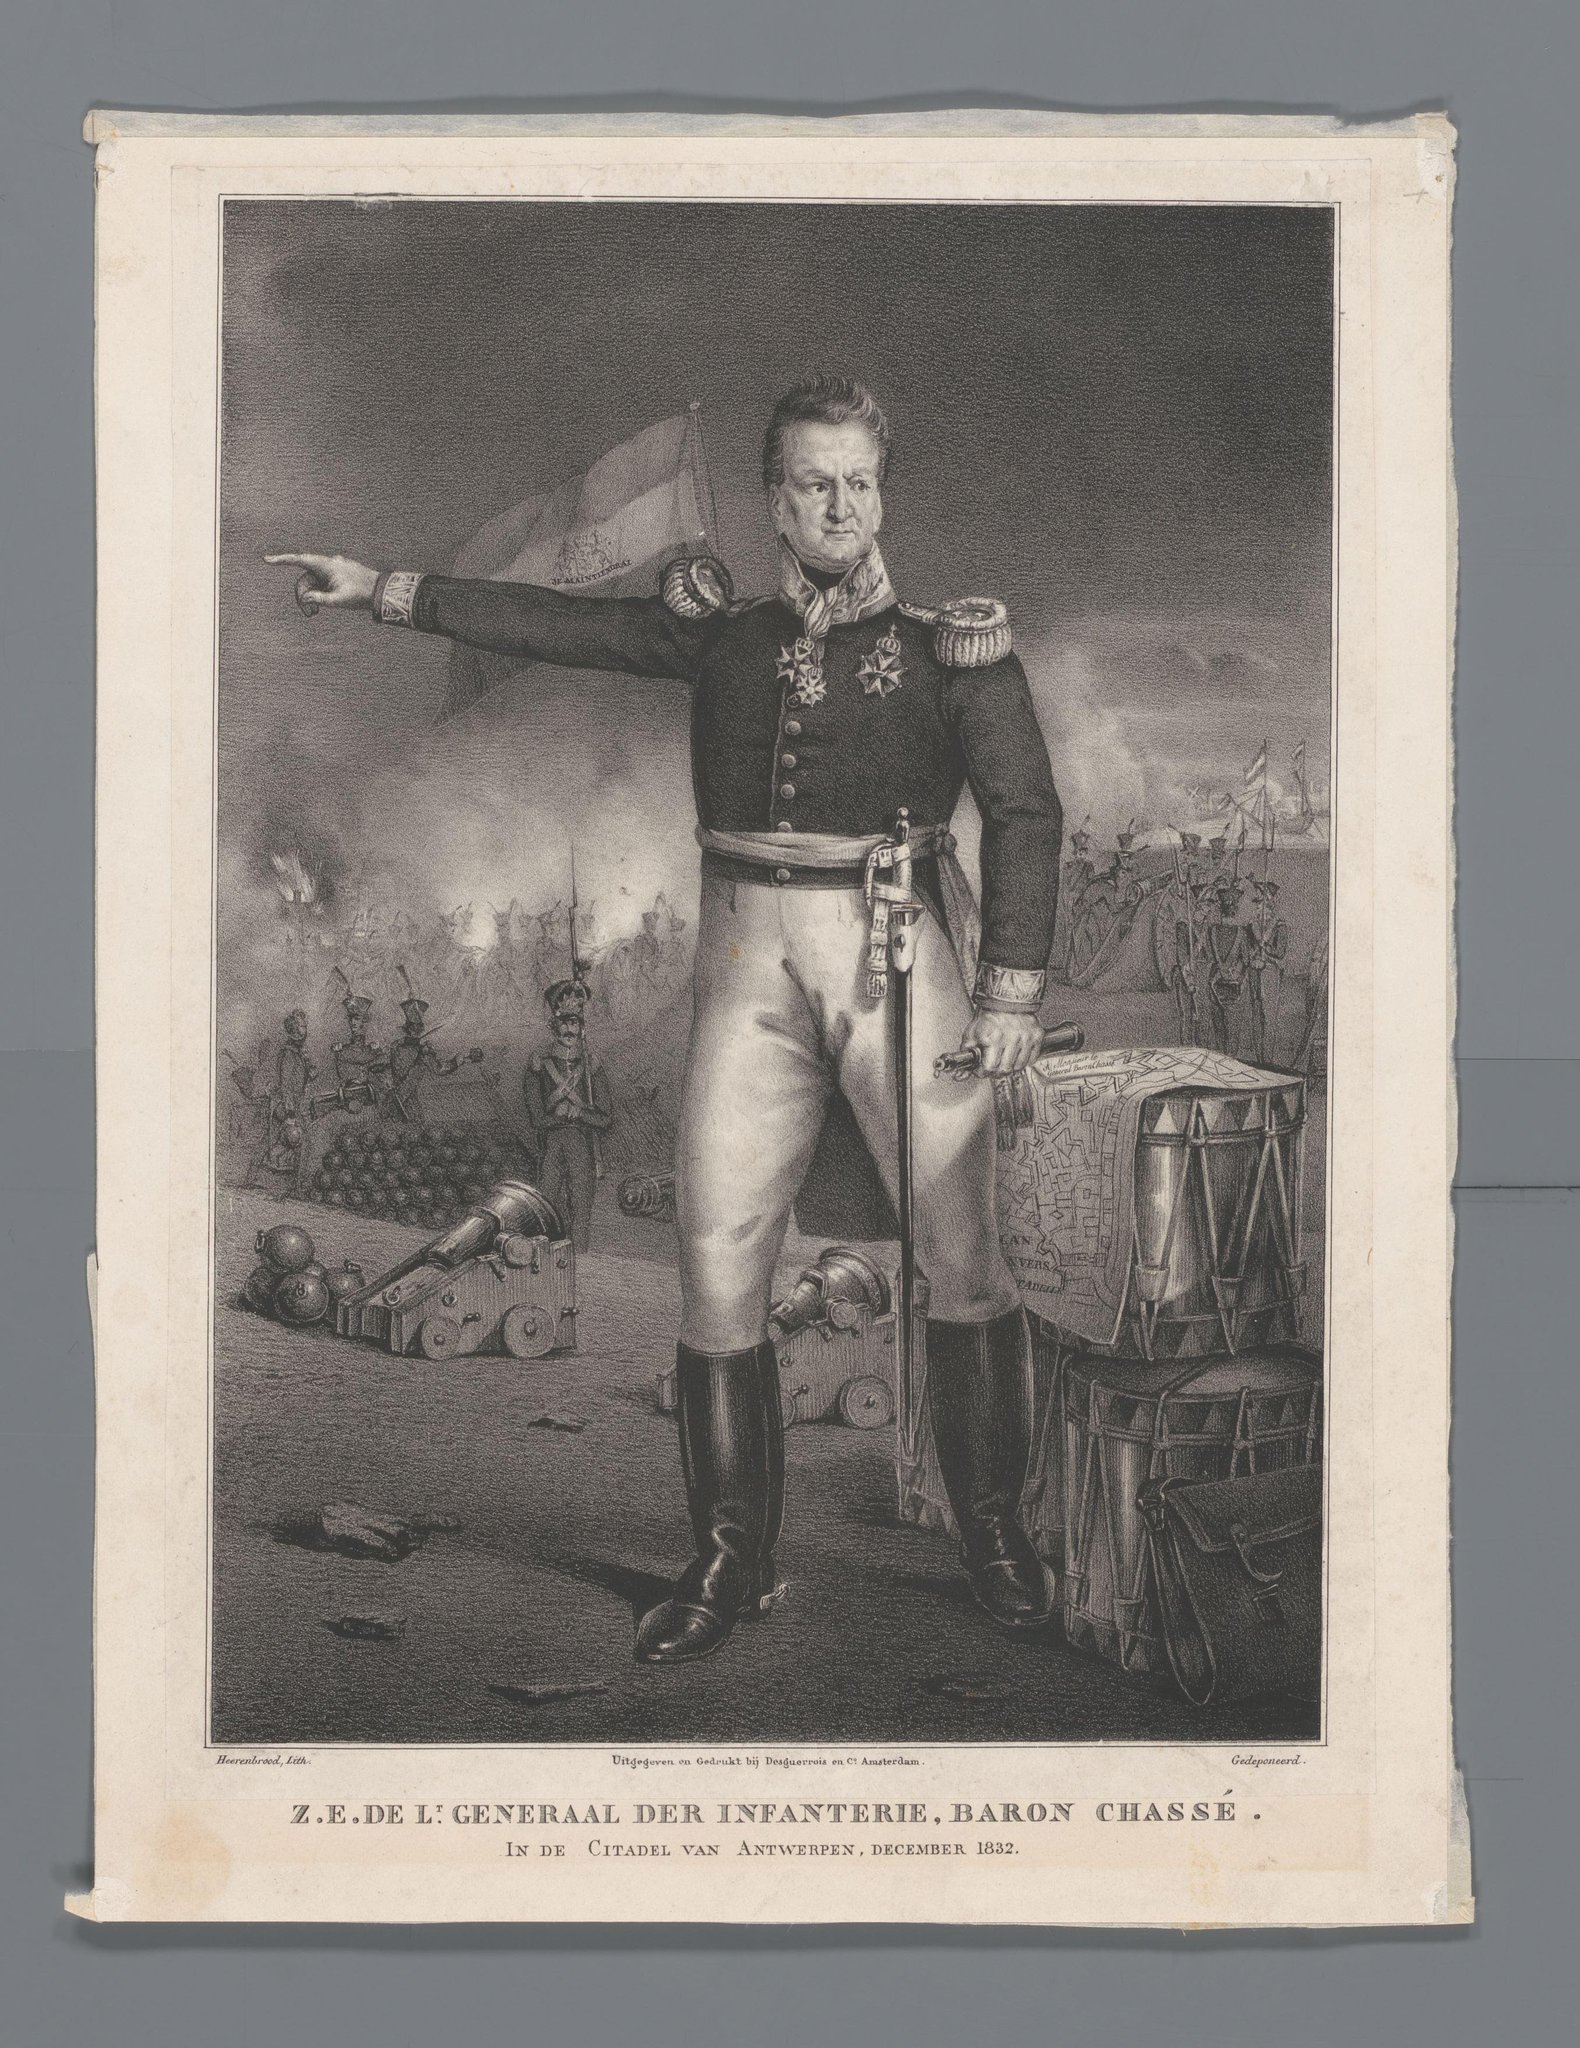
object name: print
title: Z.E. De Lt. Generaal der Infanterie, Baron Chassé. In de Citadel van Antwerpen, december 1832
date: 1833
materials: paper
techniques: lithograph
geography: amsterdam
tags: david hendrik baron chassé, historical persons, defence ~ siege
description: Portret van Baron Chassé. Staande ten voeten uit, met rechterhand naar links wijzend, in linkerhand verrekijker. Rechts drie trommels waarop kaart (Antwerpen), achter hen (Nederlandse) vlag en krijgstafereel.